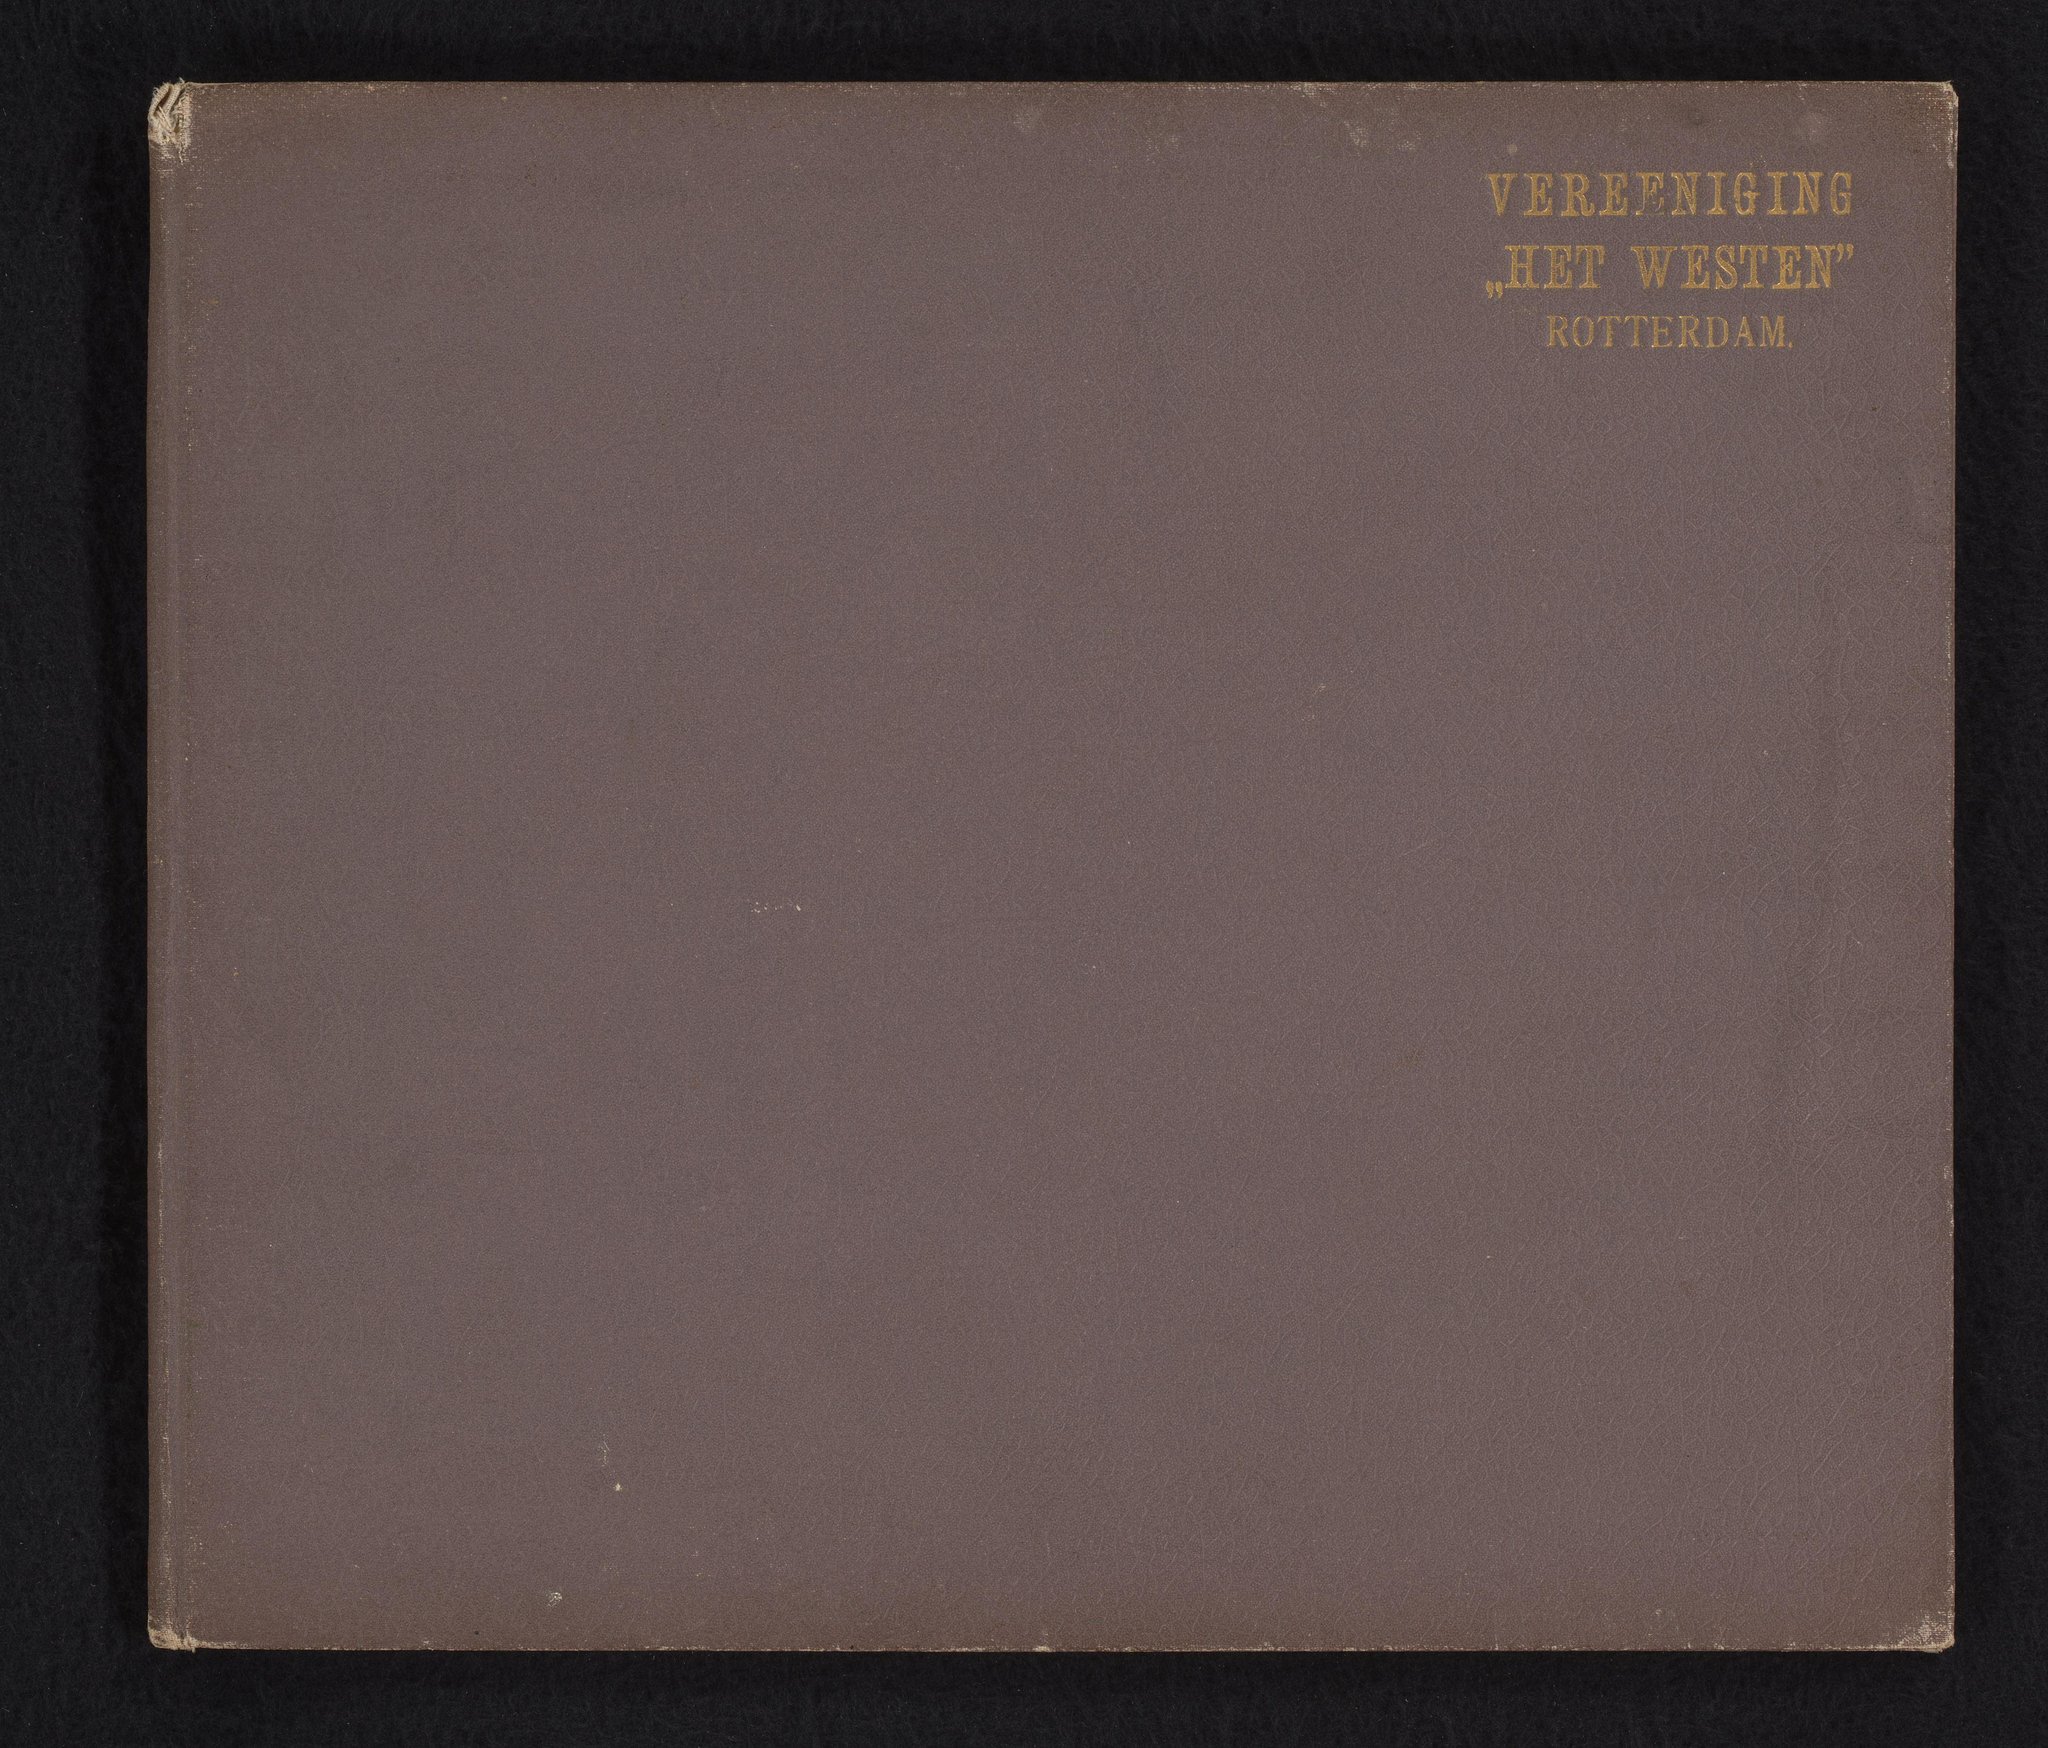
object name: photograph album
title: Fotoalbum met stadsgezichten van Rotterdam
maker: Anonymous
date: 1908-1913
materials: cardboard, linen, paper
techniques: autotype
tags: city-view in general; 'veduta', street (+ city(-scape) with figures, staffage), rotterdam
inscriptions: annotation: ‘95,-/ [343]’, inscription: ‘Aangeboden/ door de Vereeniging "Het Westen"/ te Rotterdam/ Maart 1913’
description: Fotoalbum met 18 stadsgezichten te Rotterdam. Onder andere te zien zijn de Mathenesserlaan, de Heemraadssingel en de Aelbrechtskolk.